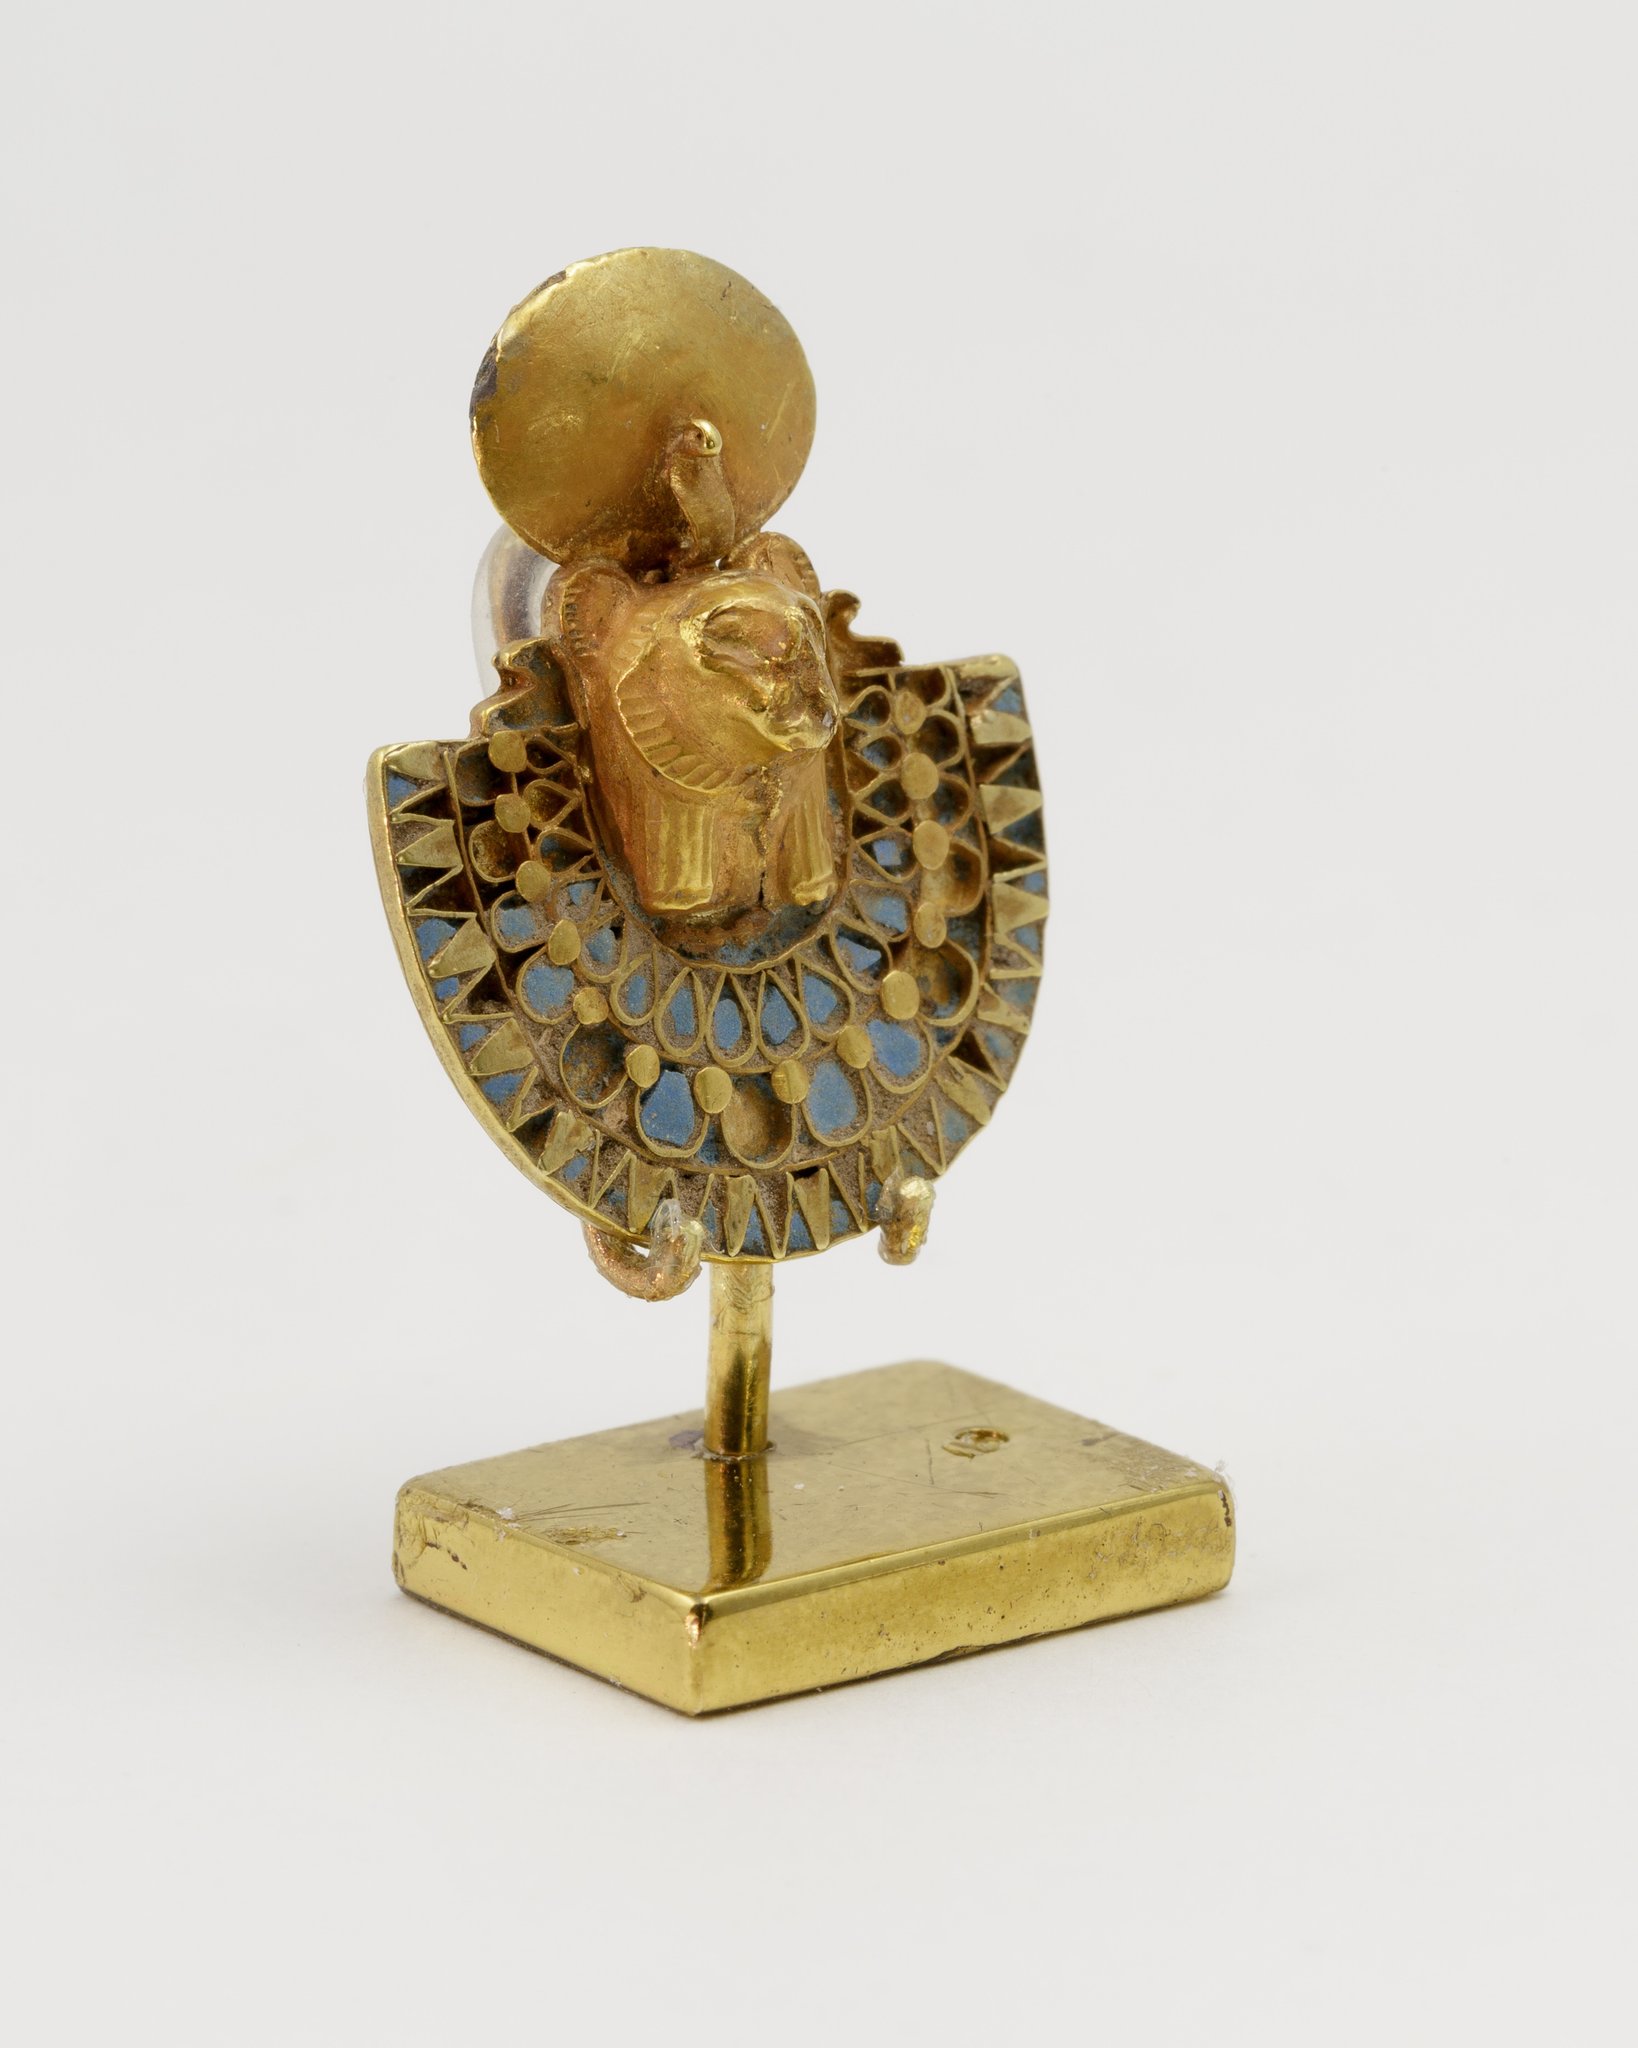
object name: amulet, aegis, bastet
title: Amuletic aegis of Bastet or Sakhmet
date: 1070-664 BCE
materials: gold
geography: egypt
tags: goddess